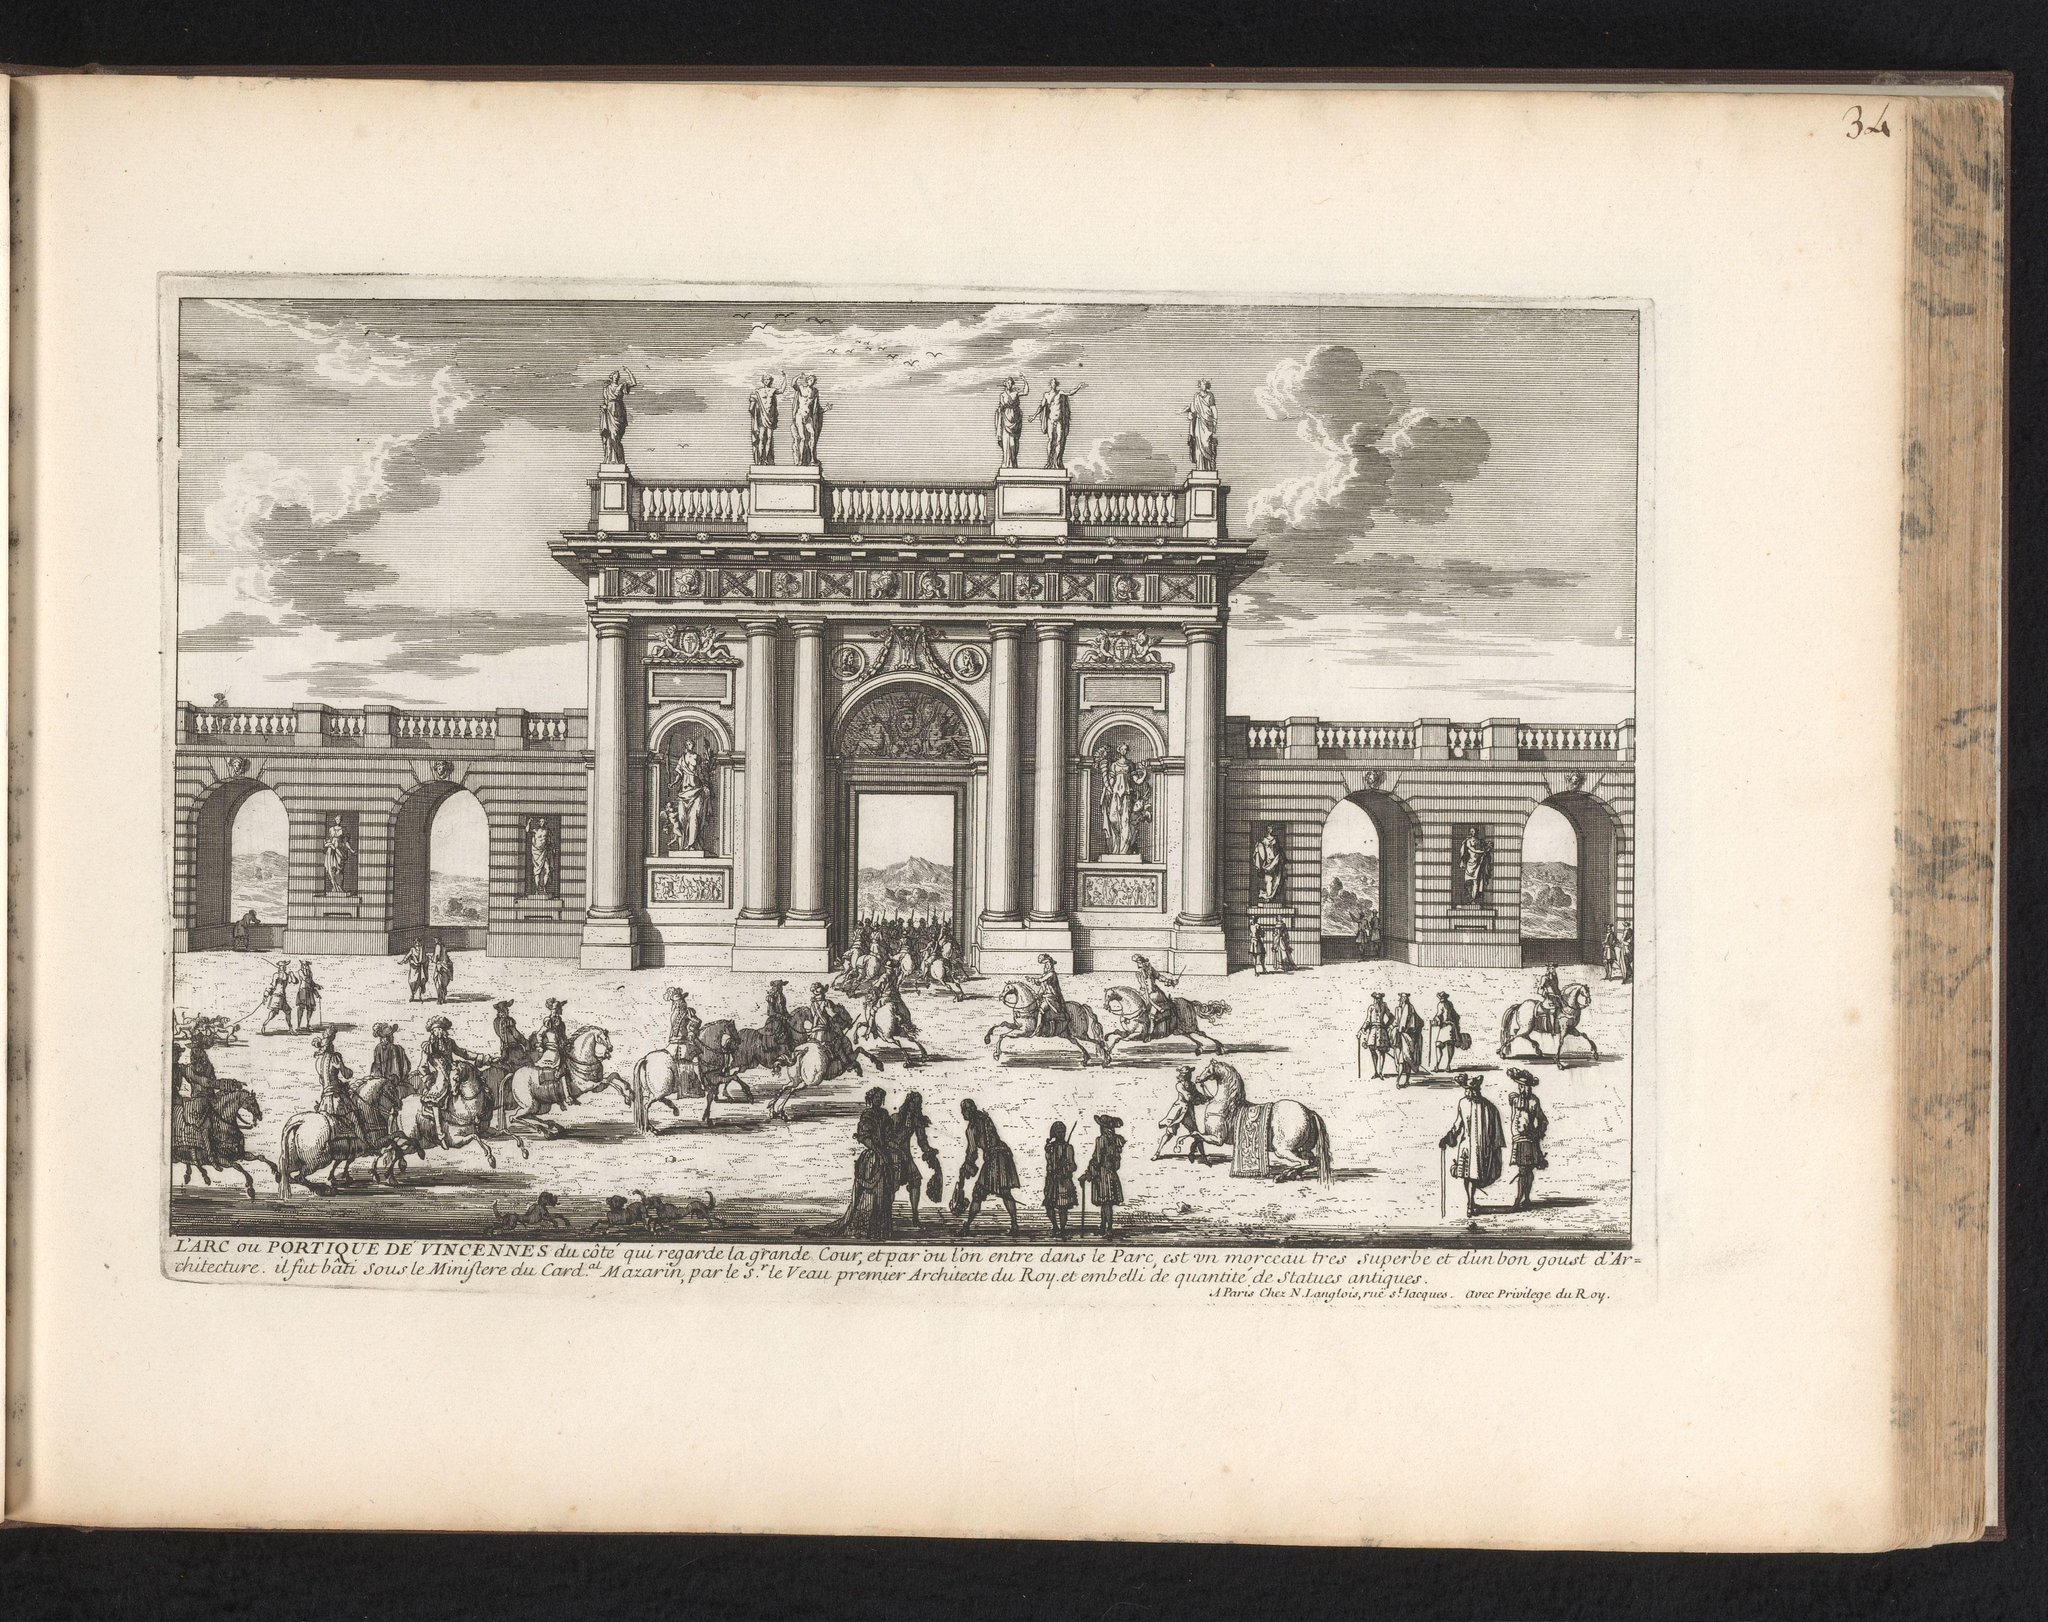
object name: print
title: Stadsgezichten en landschappen in Frankrijk en Italië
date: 1660-1703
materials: paper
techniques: etching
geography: france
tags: riding a horse, ass, or mule; rider, horseman, castle, arch, archivolt ~ architecture, landscape with tower or castle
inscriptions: collector's mark: Lugt 2228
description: Prenten met het signatuur 'Perelle' kunnen zowel door vader Gabriel als door zonen Nicolas en Adam gemaakt zijn. De uitgevers vader en zoon Nicolas Langlois worden allebei vermeld als N. Langlois op hetzelfde adres.